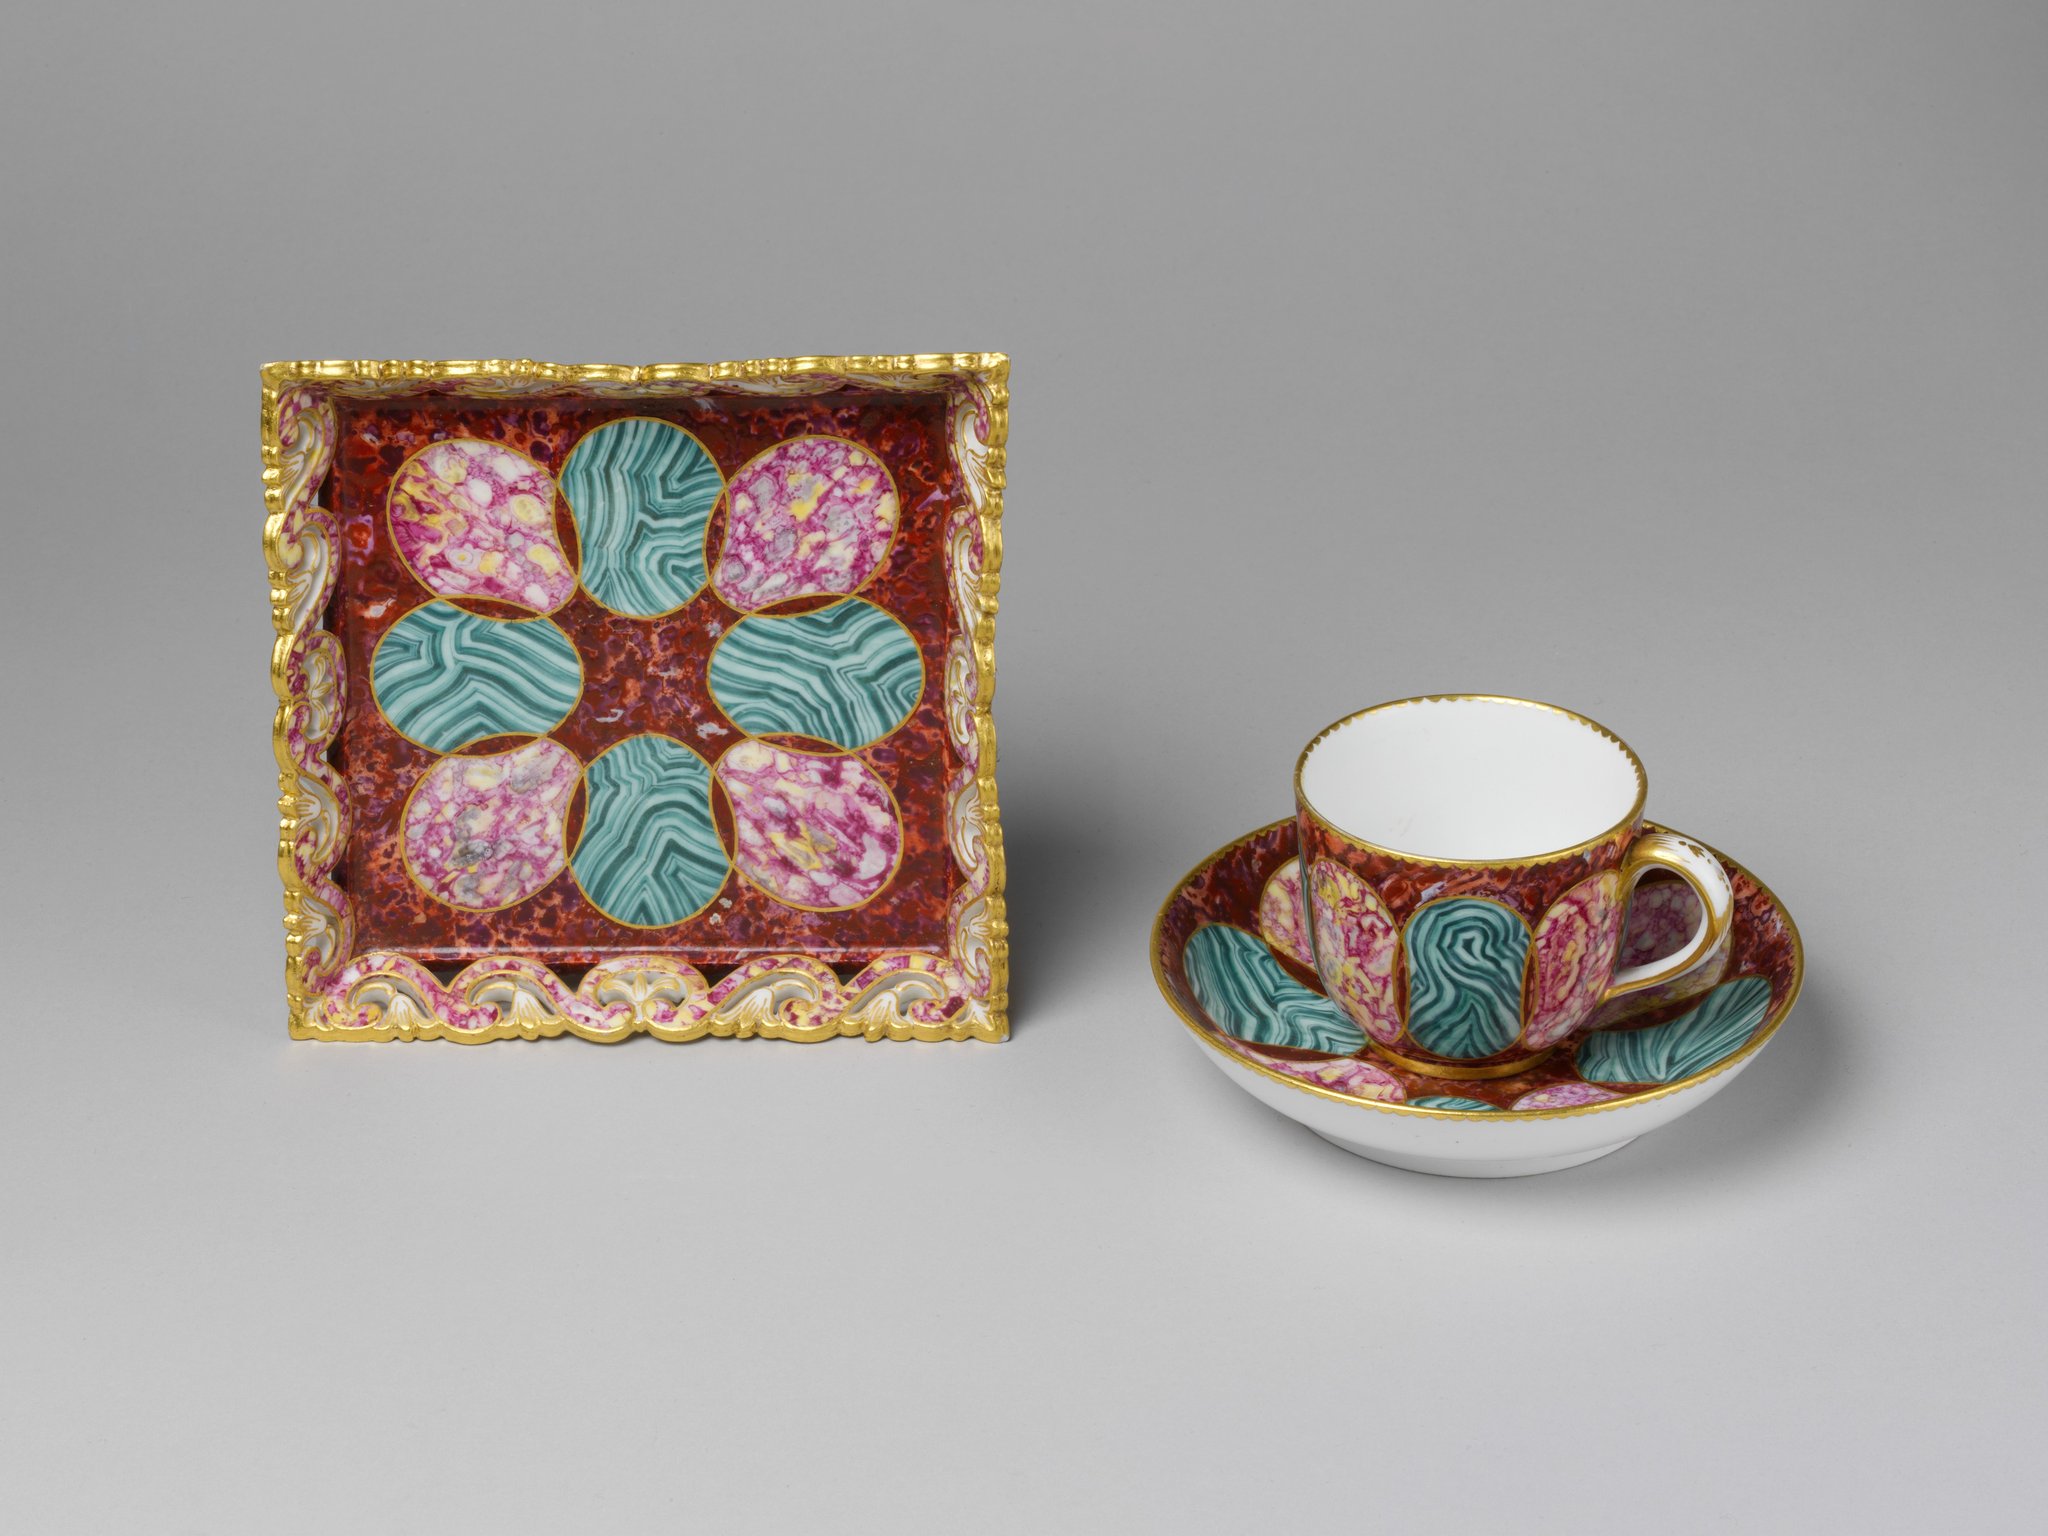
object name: small tray, cup and saucer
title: Small tray, cup and saucer (déjeuner carré)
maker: sèvres manufactory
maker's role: manufactory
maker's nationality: french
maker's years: 1740-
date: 1765-1770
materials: soft paste porcelain